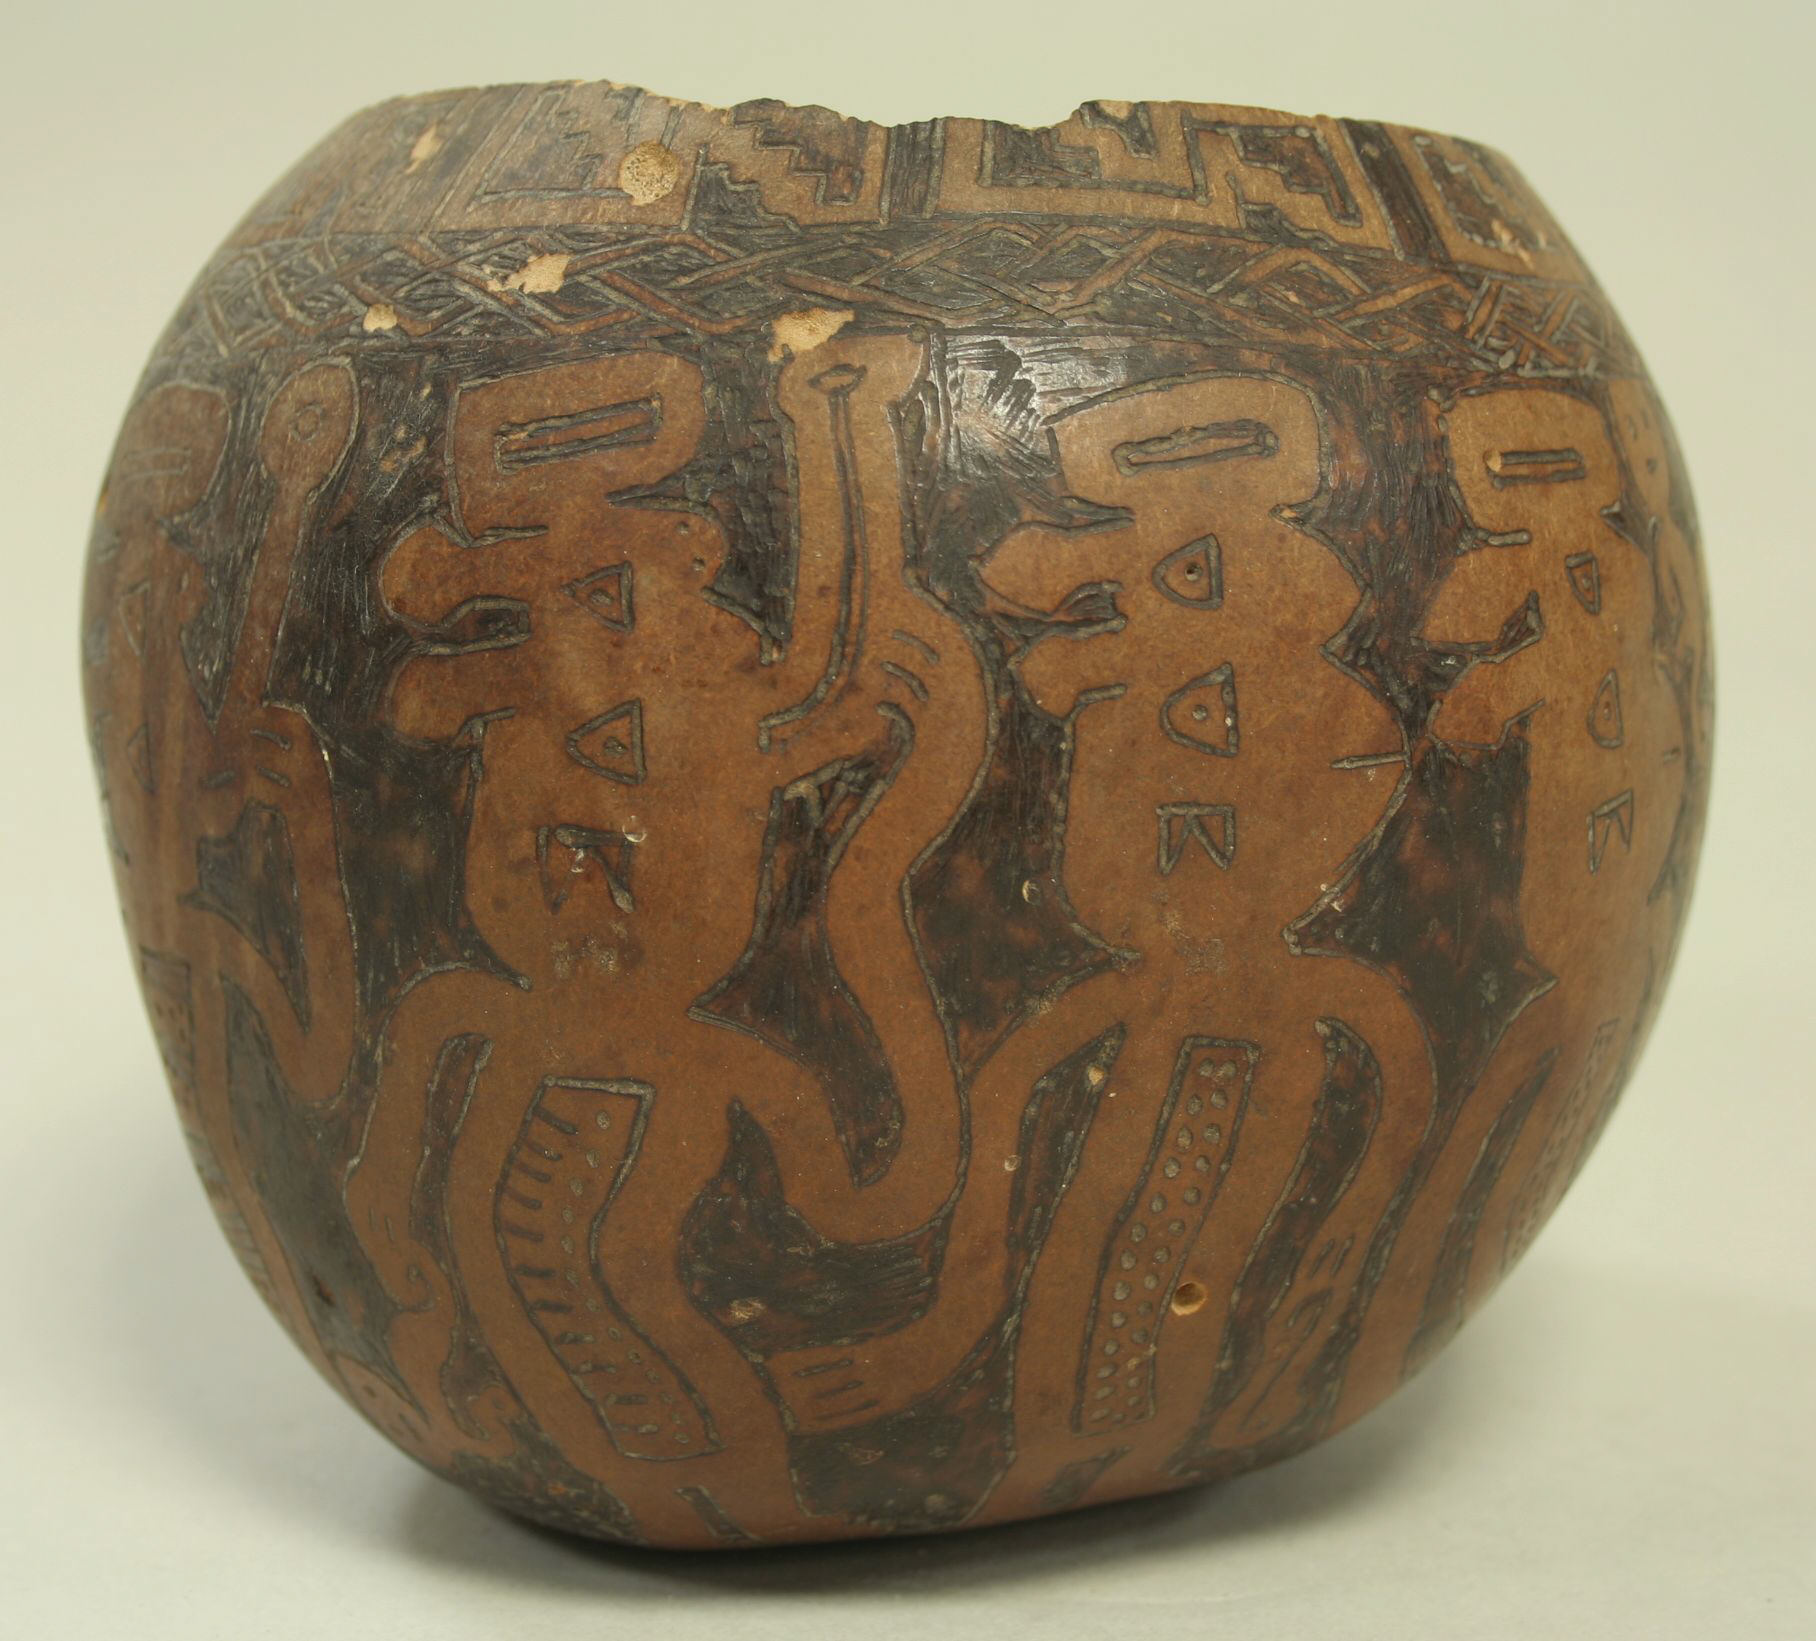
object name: vessel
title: Incised Gourd Vessel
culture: central or south coast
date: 200 BCE-300 CE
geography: peru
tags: vegetables